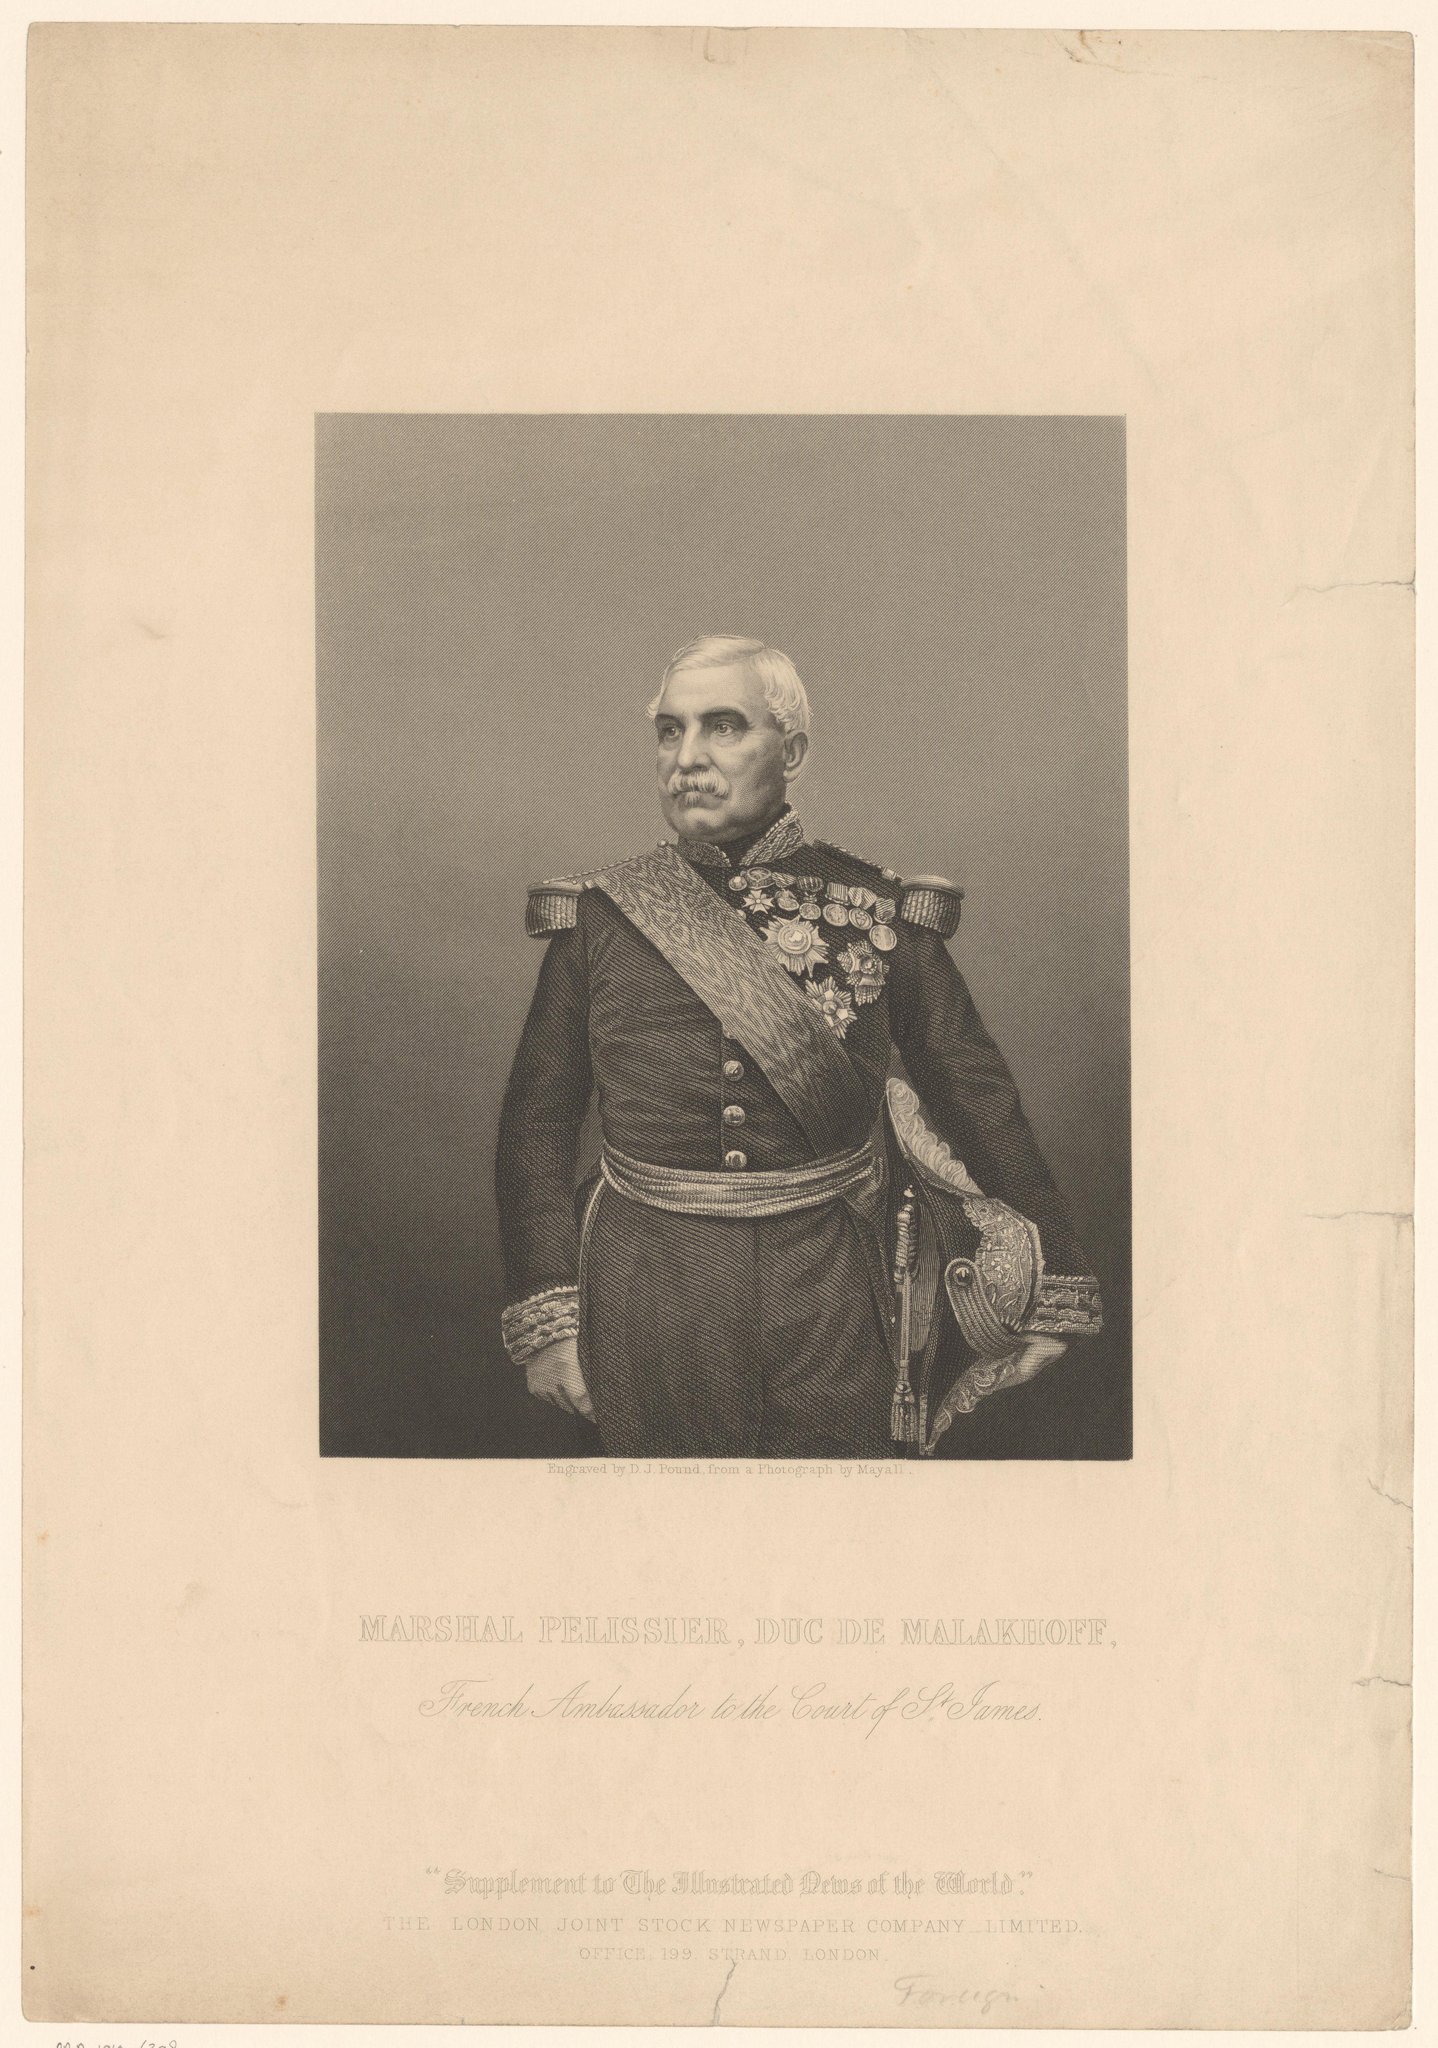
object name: book illustration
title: Marshal Pelissier, Duc de Malakhoff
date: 1859-1862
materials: paper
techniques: engraving, etching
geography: london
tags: commander-in-chief, general, marshal, historical persons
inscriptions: collector's mark: Lugt 2228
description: Prent mogelijk uit: The drawing-room portrait gallery of eminent personages. Londen: London Joint Stock Newspaper Company, 1859-1862.